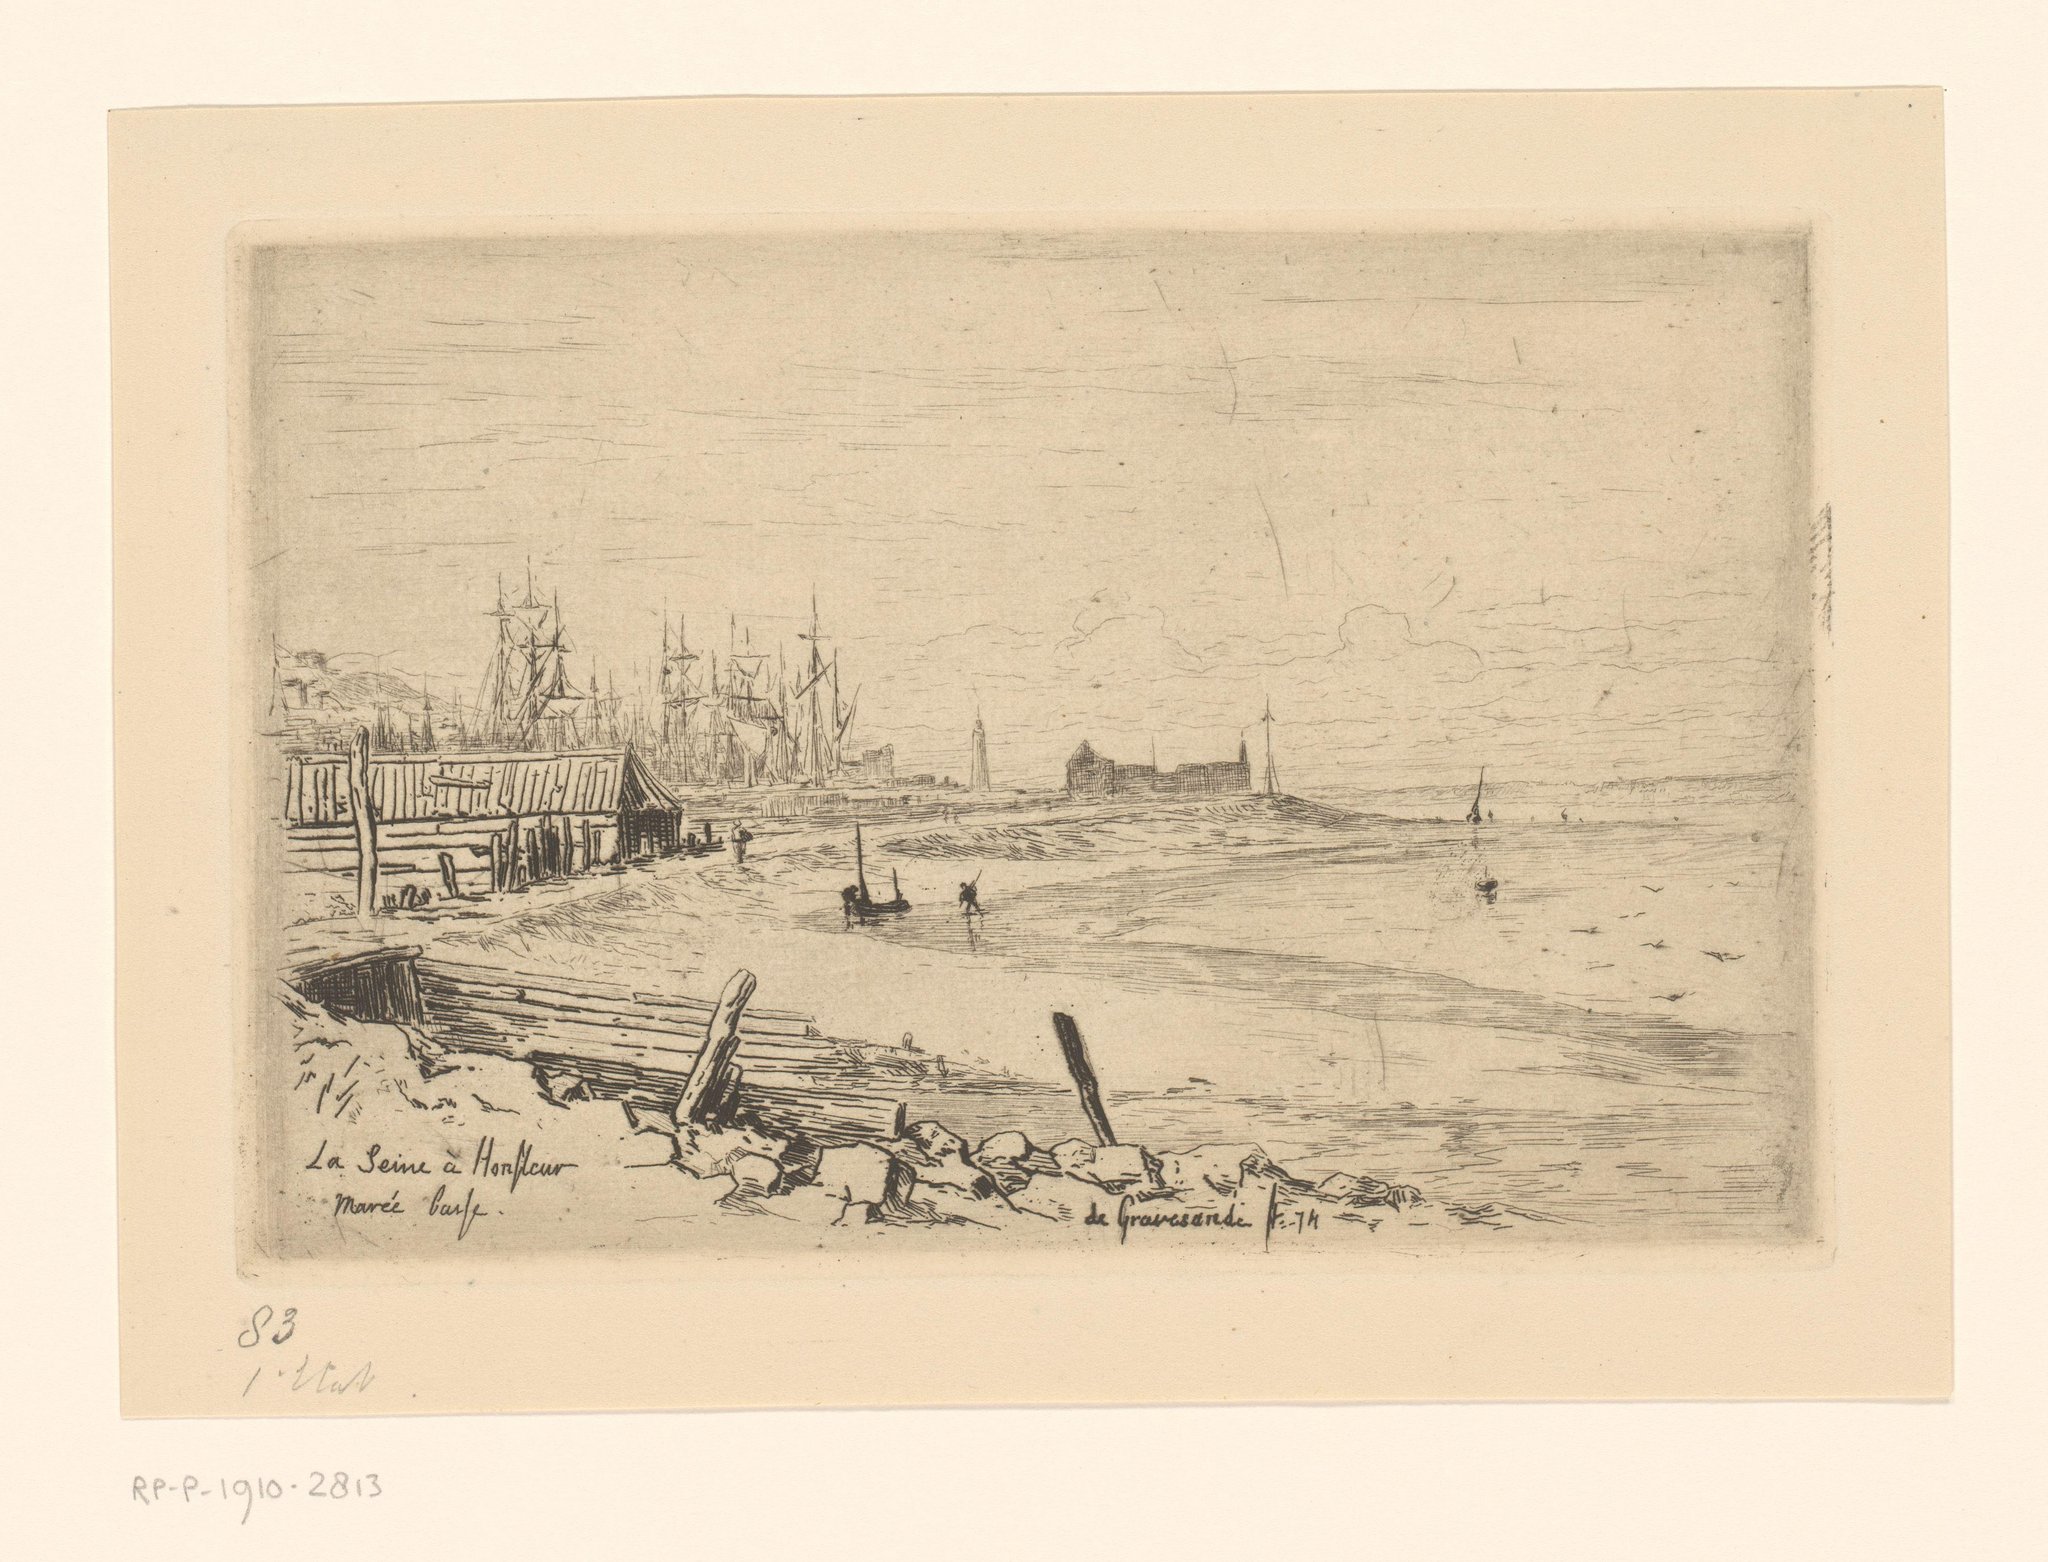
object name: print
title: La Seine à Honfleur, marée basse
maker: carel nicolaas storm van s-gravesande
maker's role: draughtsman, print maker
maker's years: 1841-1924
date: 1874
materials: paper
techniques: etching, intaglio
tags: ebb, low tide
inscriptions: collector's mark: Lugt 2228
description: De oever van de Seine bij Honfleur bij laag water.